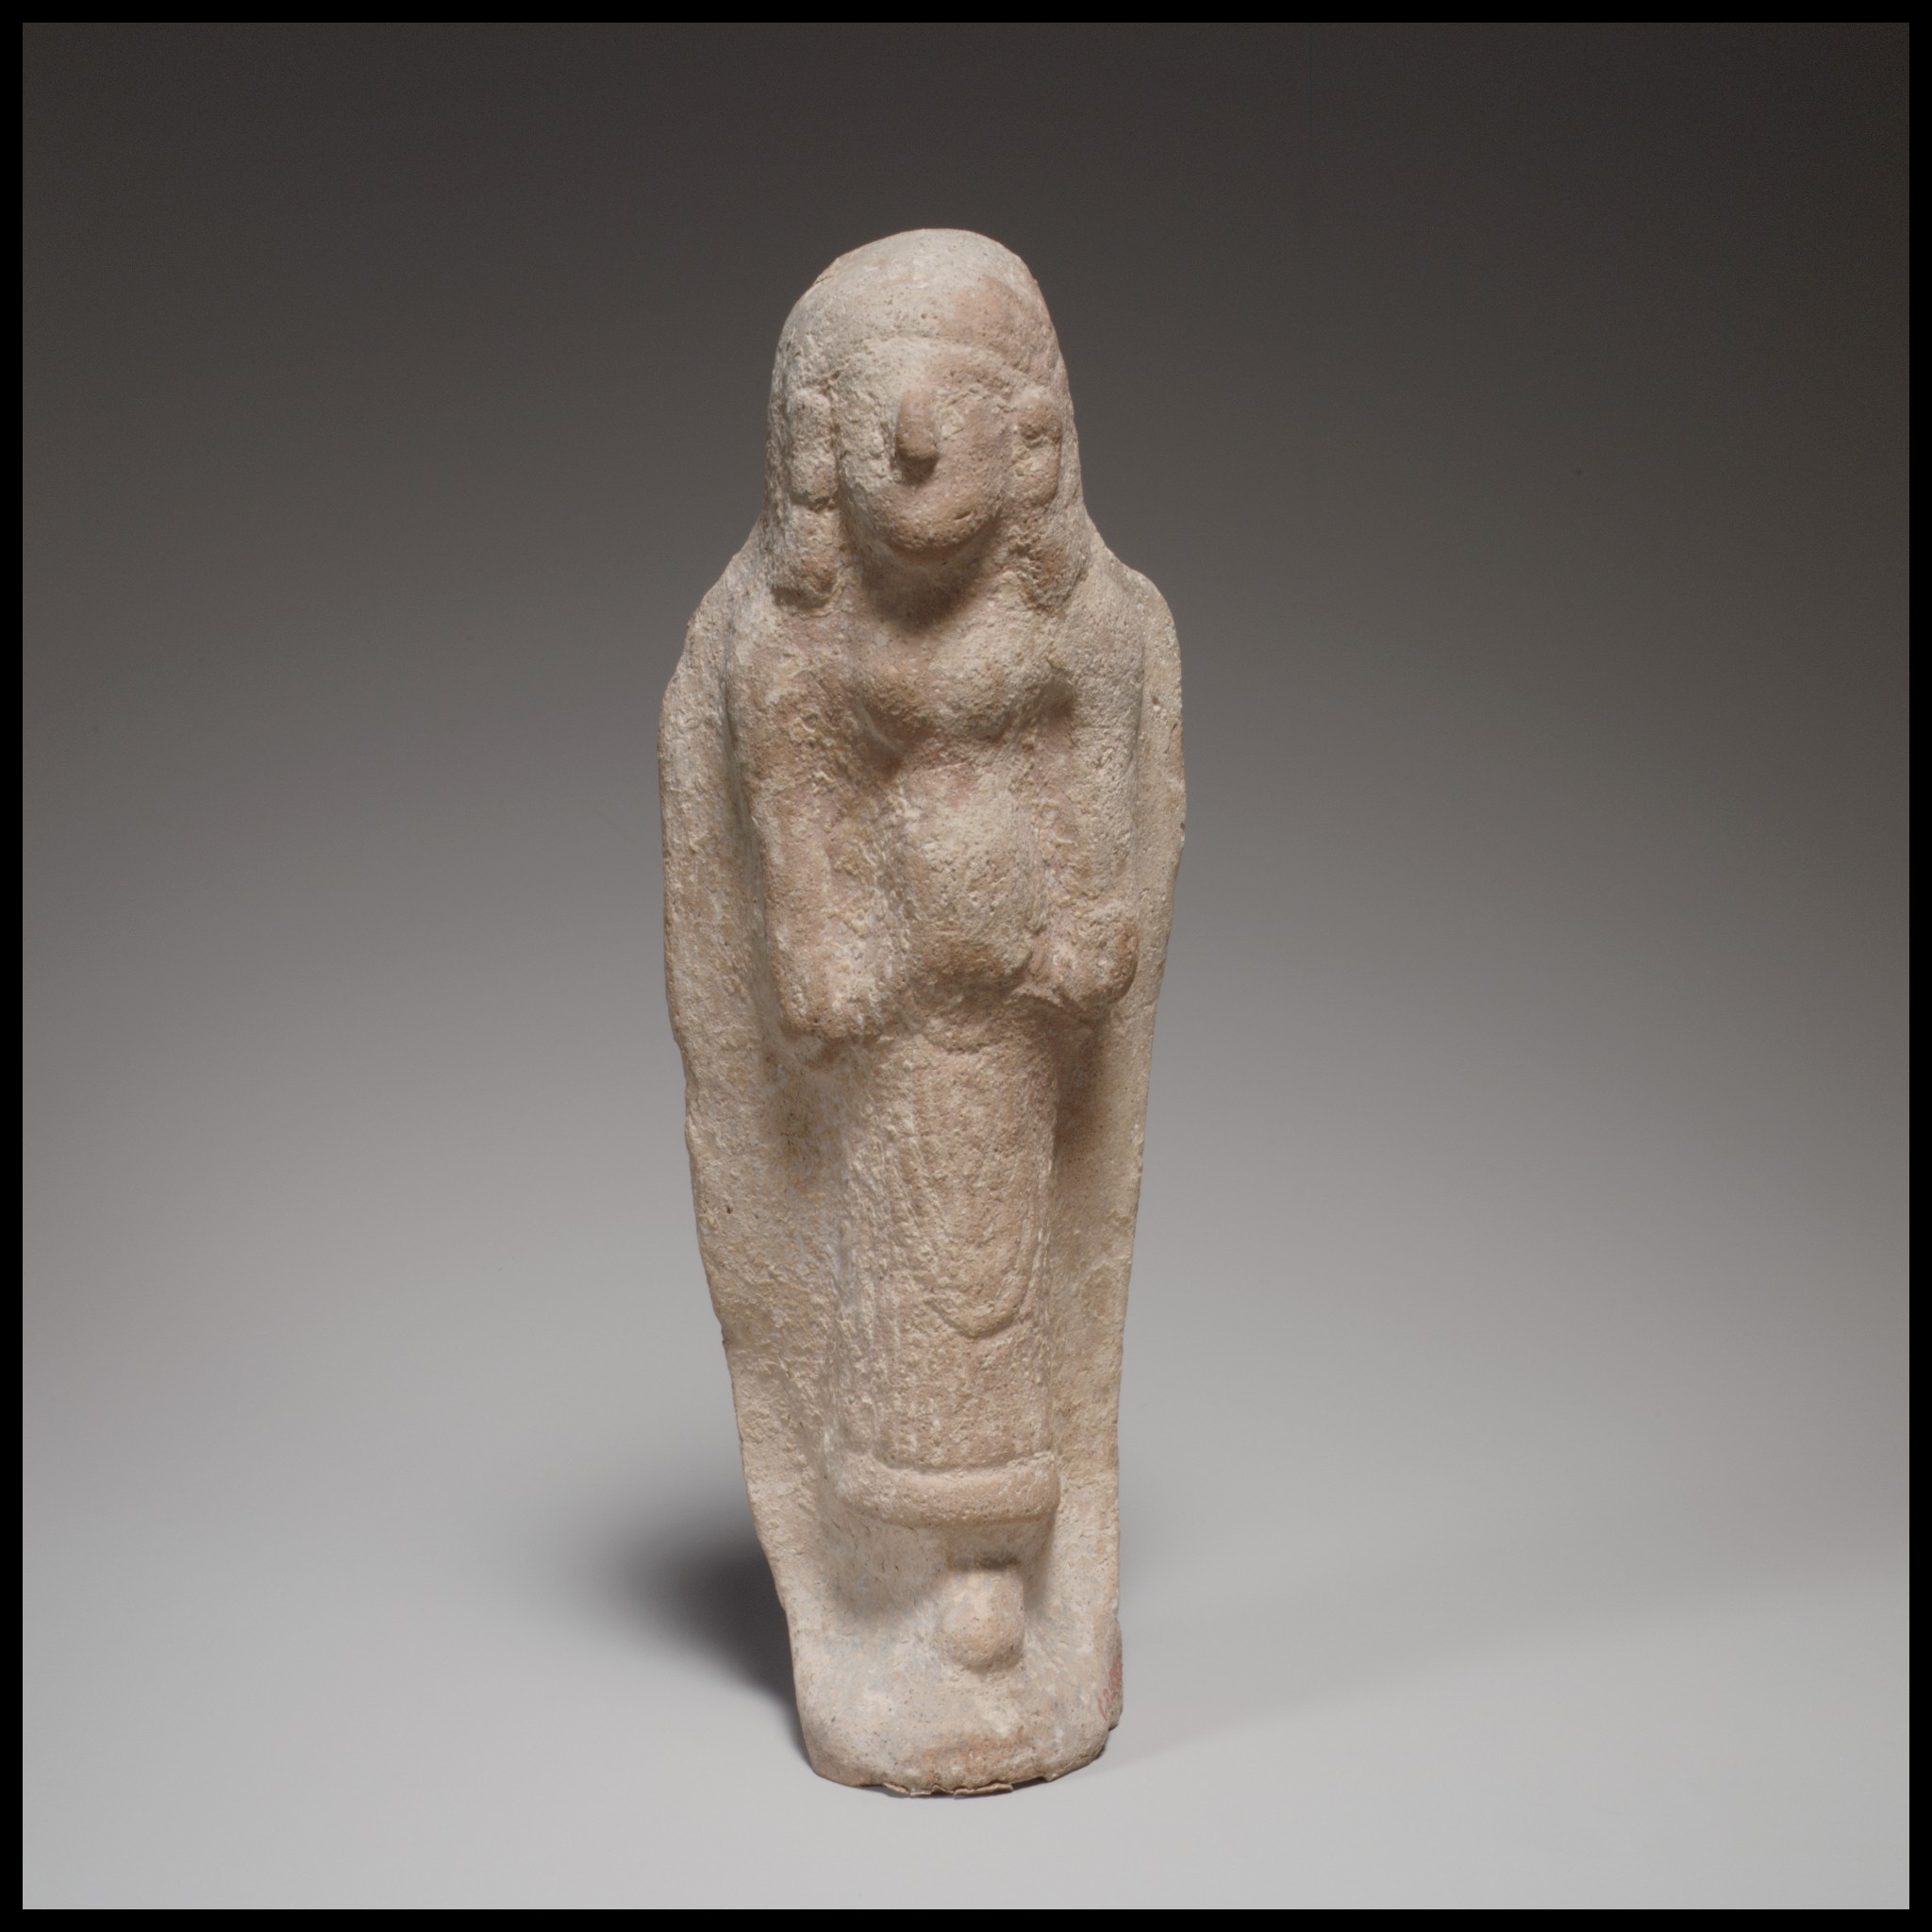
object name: statuette of a woman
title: Standing female figurine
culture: cypriot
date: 600-480 BCE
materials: terracotta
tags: women